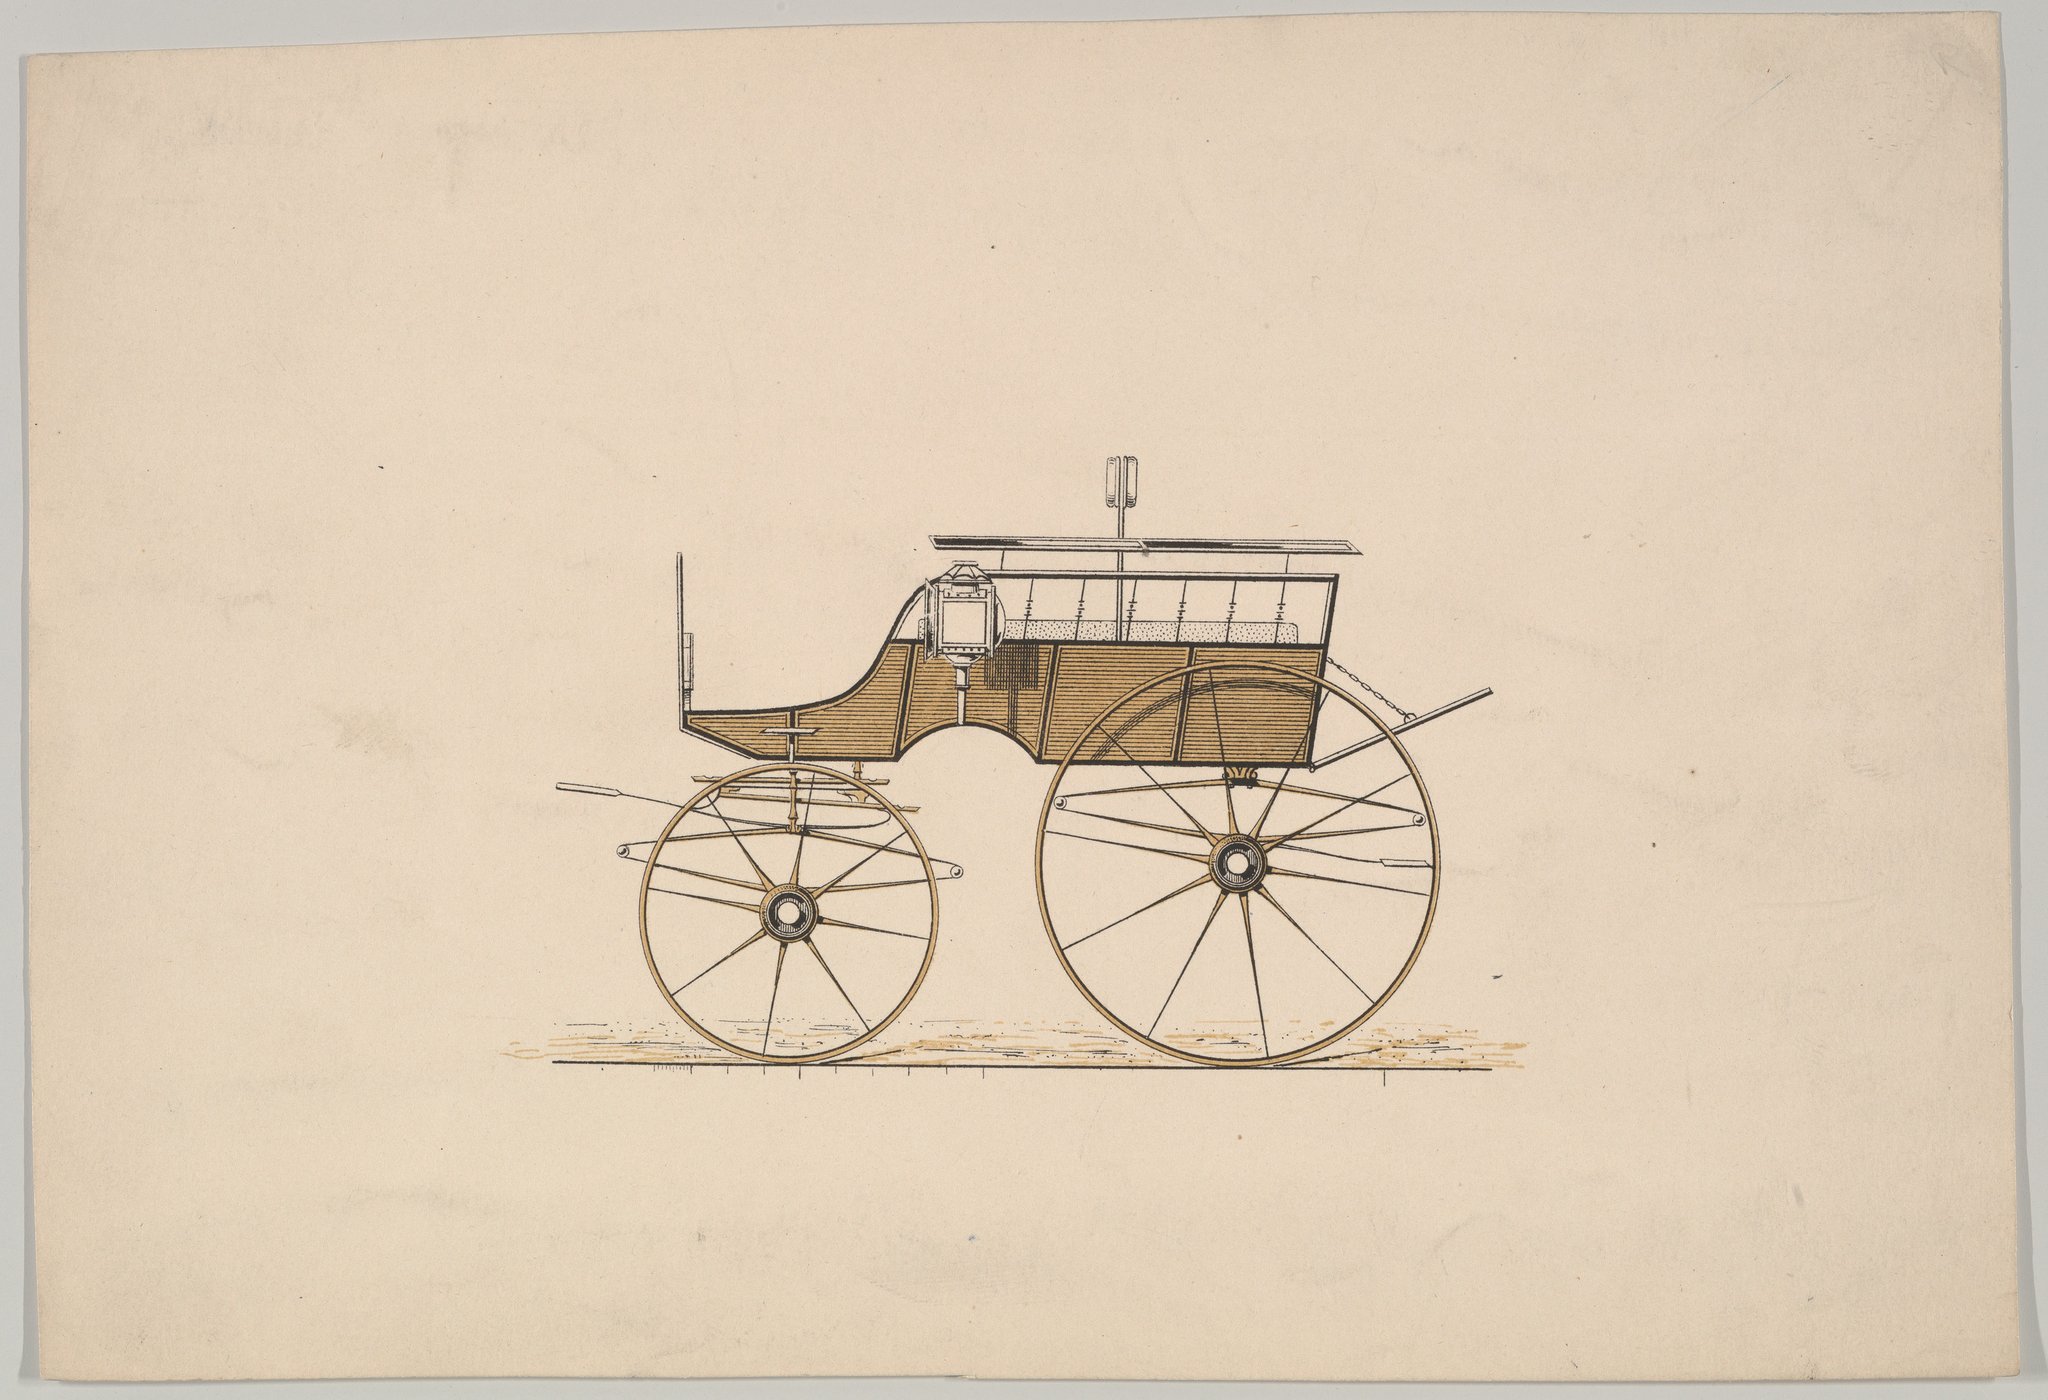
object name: drawing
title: Dos-a-Dos Phaeton unnumbered)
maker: brewster & co.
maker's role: manufacturer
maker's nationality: american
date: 1850-1870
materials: gouache, ink, watercolor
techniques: pen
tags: carriages